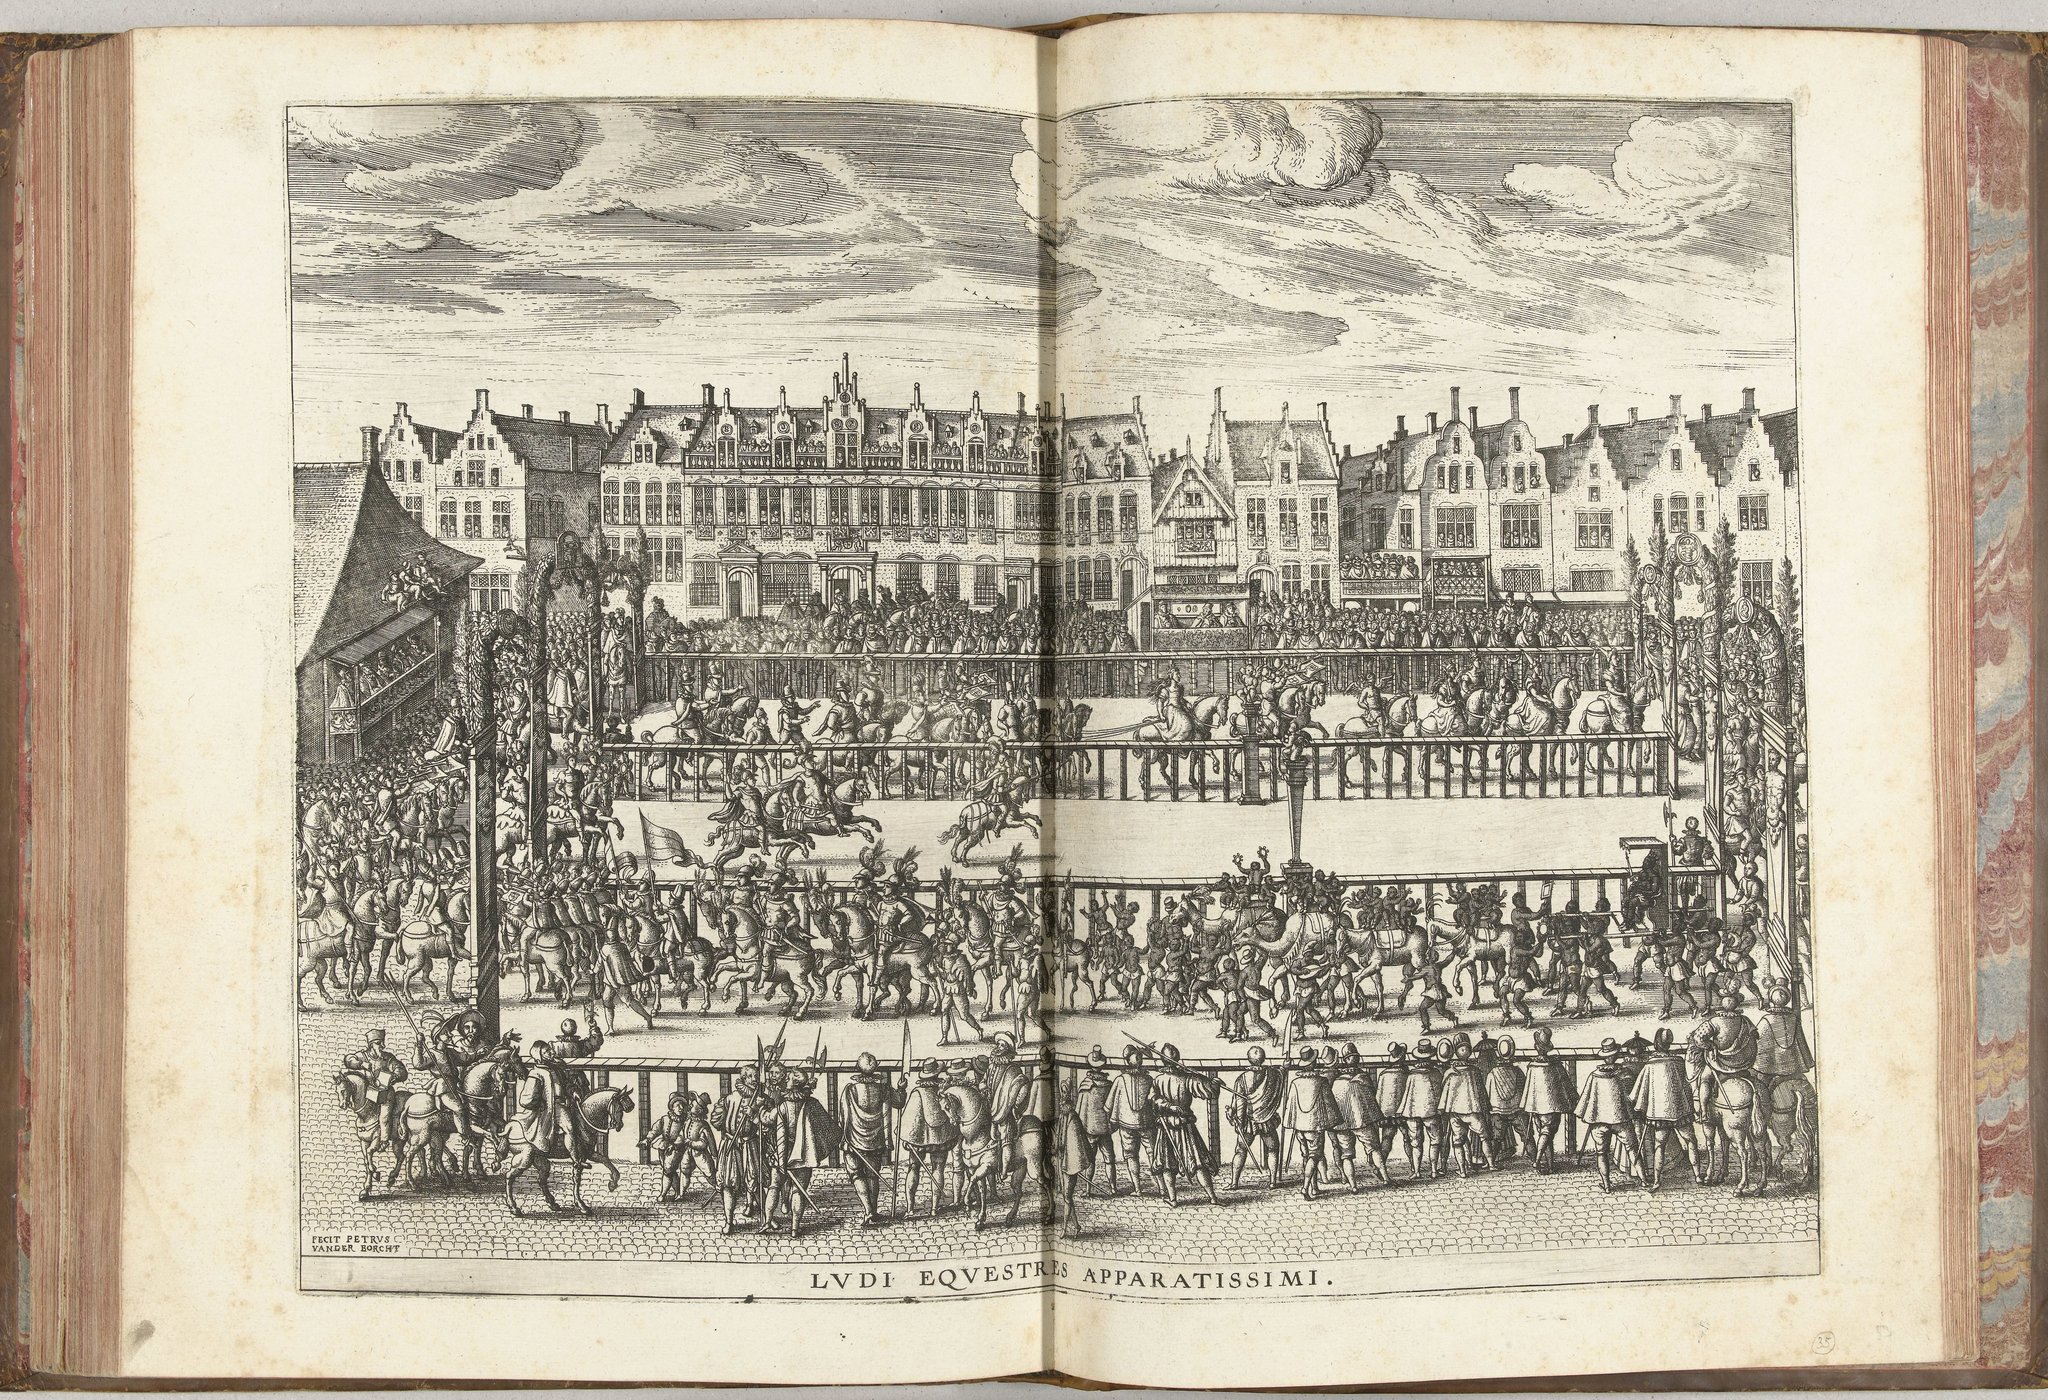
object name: print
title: Ludi Equestres Apparatissimi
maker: pieter van der borcht (i)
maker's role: print maker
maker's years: 1545-1608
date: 1594-1595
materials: paper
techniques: etching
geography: antwerp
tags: brussels, africans, triumphal entry and public reception, pageant, 'entrée solennelle', 'joyeuse entrée', tilting at the ring (~ games of skill), antwerp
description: Ringsteken op de Meir. Op de voorgrond een zwarte koning in een draagstoel met dragers. Voor hem uit lopen in een optocht dansende en muciserende mannen, vrouwen en kinderen en enkele paarden en kamelen. Onderdeel van de beschrijving van de intocht van aartshertog Ernst te Antwerpen, 18 juli 1594, door Joannes Bochius, Descriptio publicae gratulationis, spectaculorum et ludorum, in adventu Sereniss. Principis Ernesti Archiducis Austriae, Ex Officina Plantiniana, Antwerpen 1595.